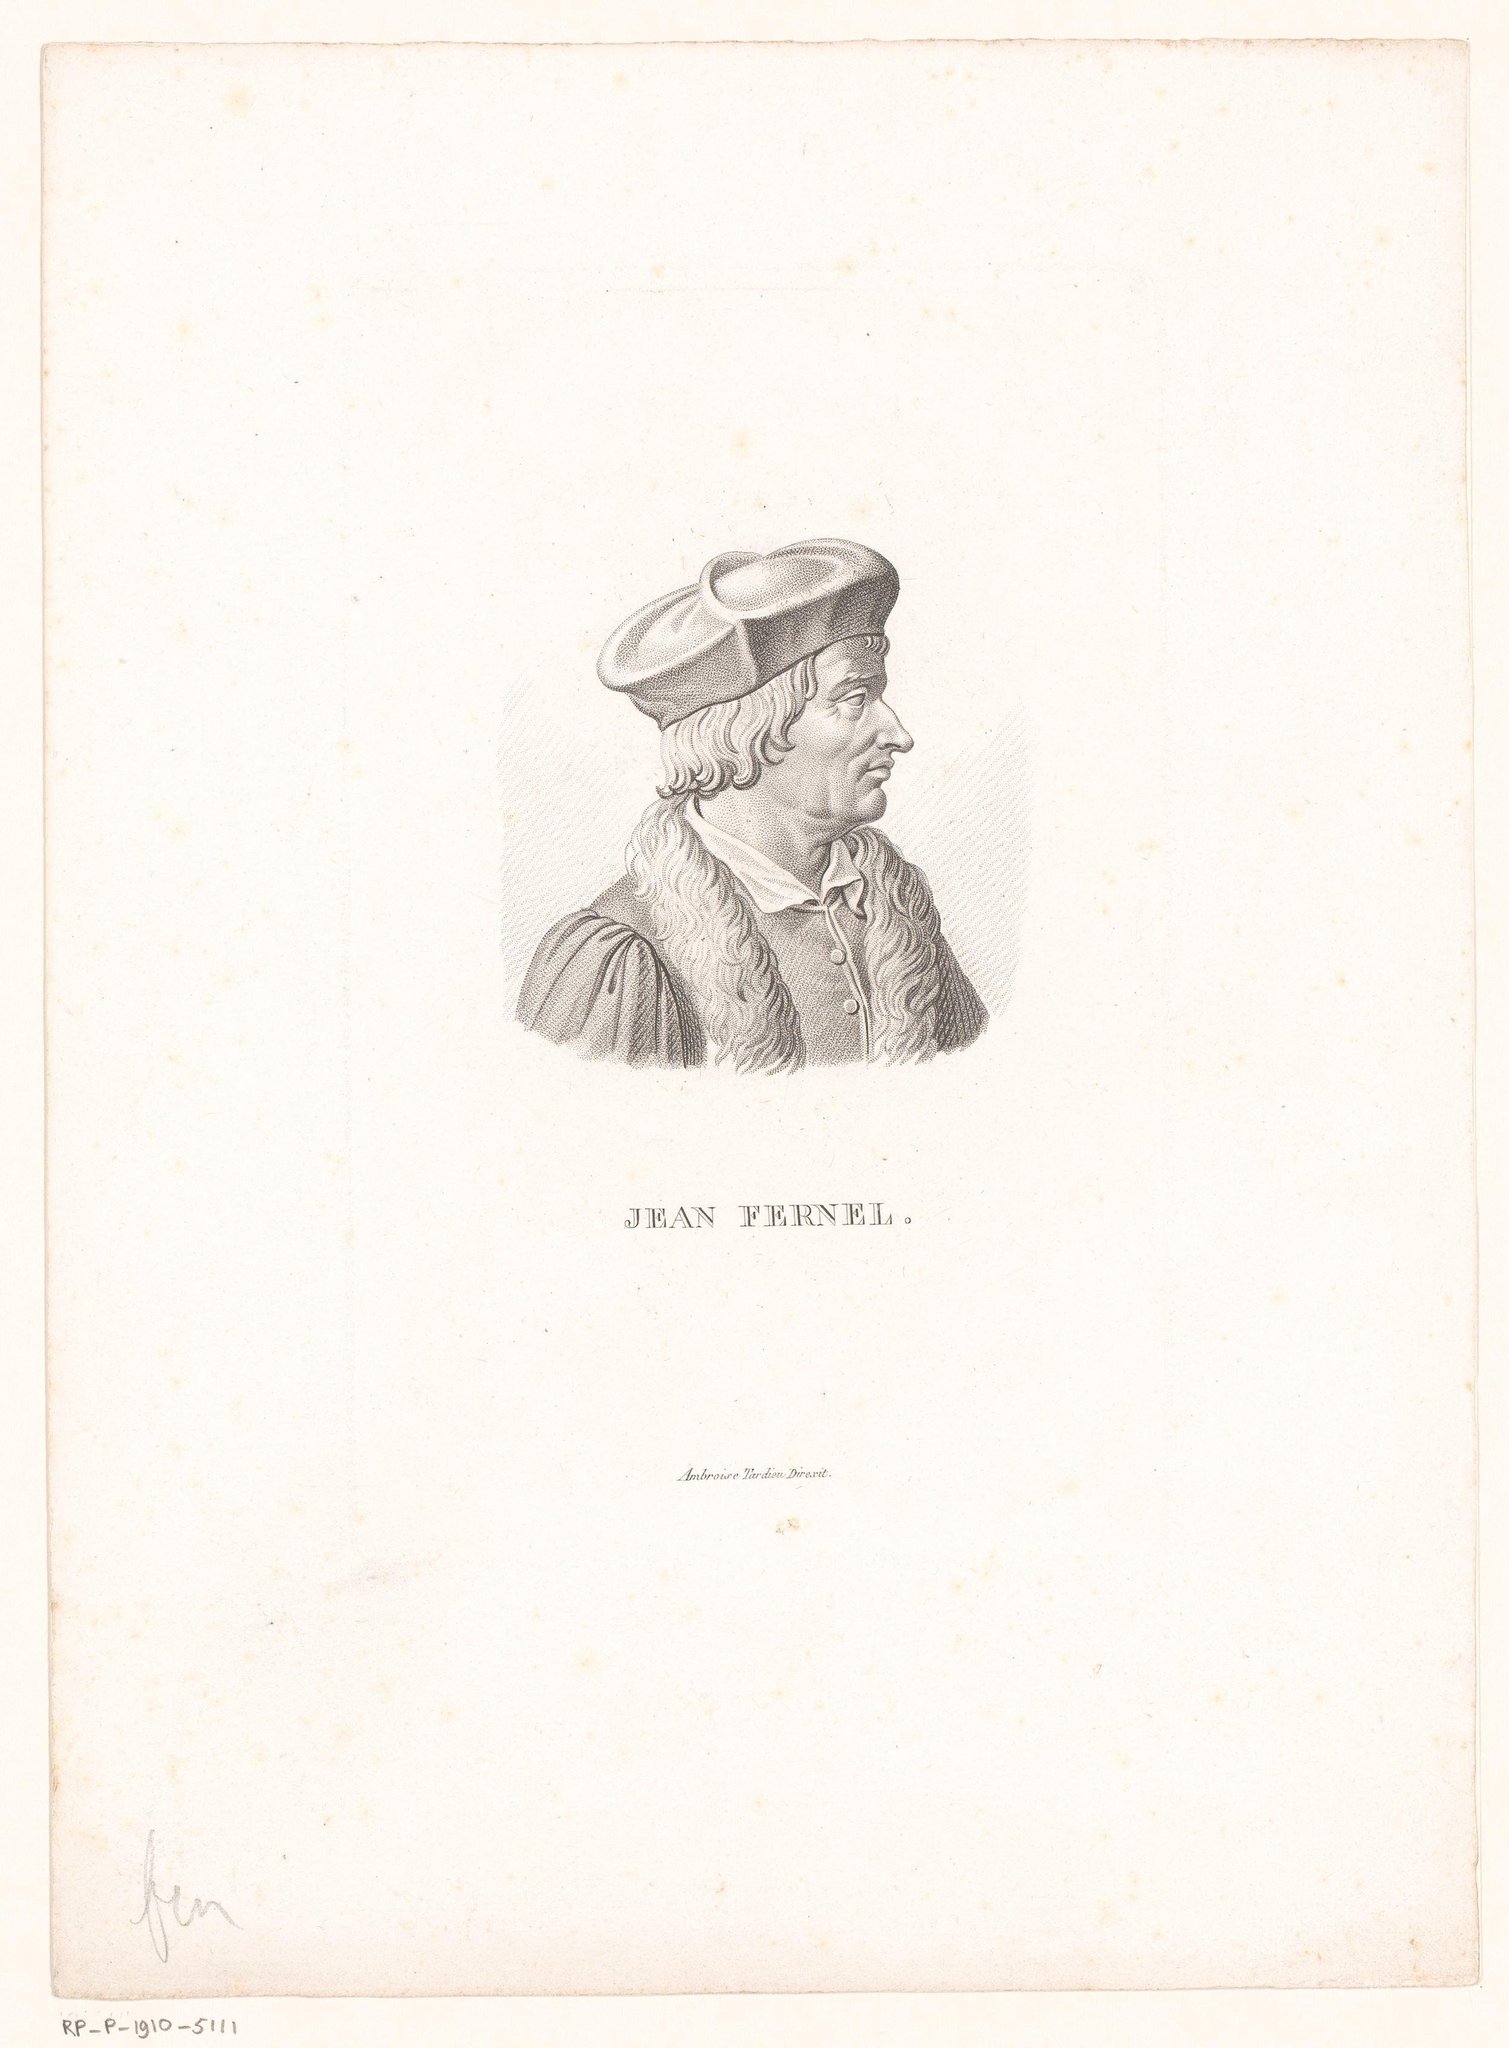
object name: print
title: Portret van Johannes Fernelius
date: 1818-1832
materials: paper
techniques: engraving, roulette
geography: paris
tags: scholar, philosopher, historical persons, physician, doctor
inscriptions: collector's mark: Lugt 2228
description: Mogelijk prent uit: Journal complémentaire du Dictionnaire des sciences médicales. Parijs: Panckoucke, Charles Louis Fleury, 1818-1832.